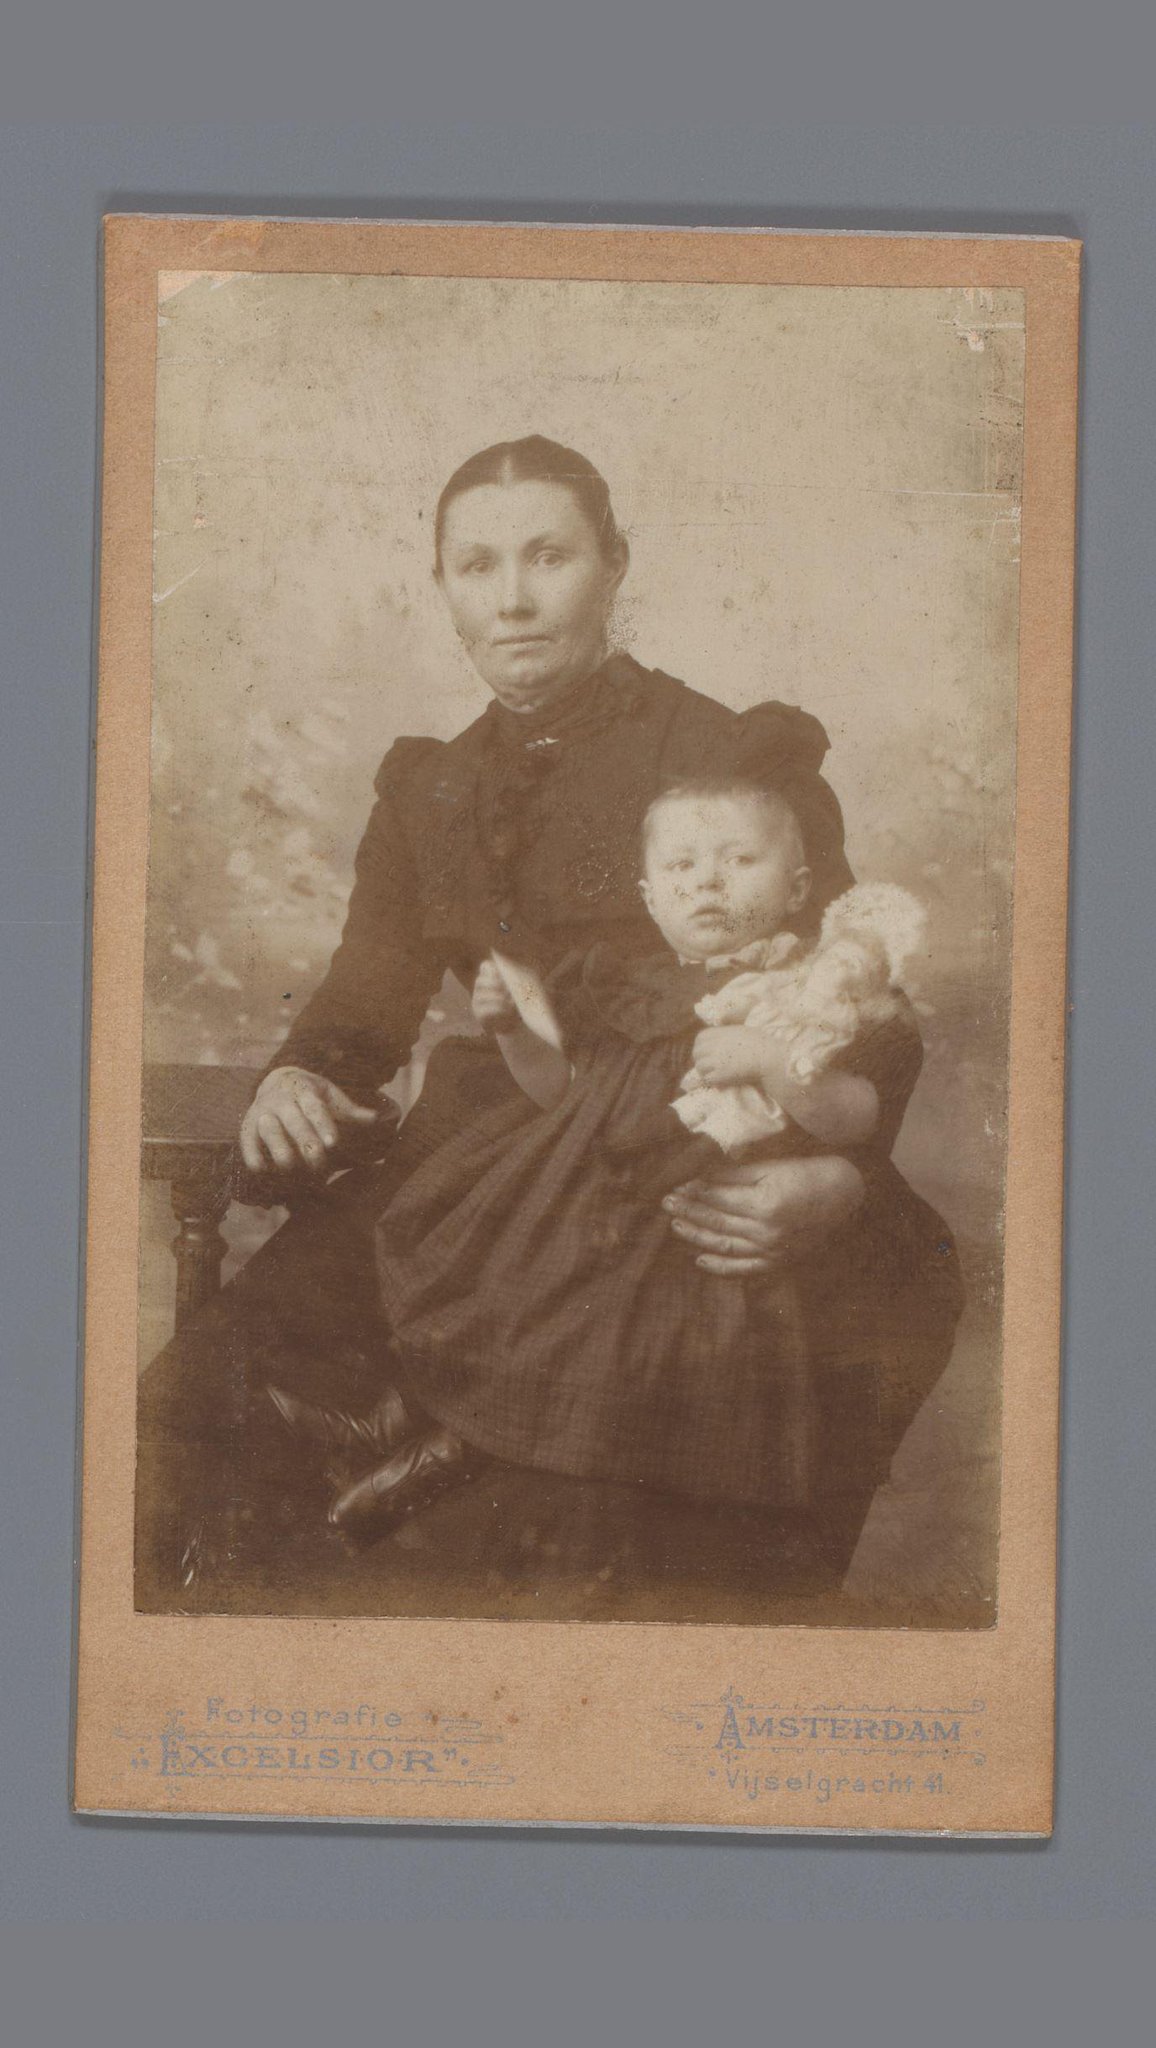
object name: carte de visite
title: Portret van een onbekende vrouw met kind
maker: wilhelmus johannes van pampus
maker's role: fotograaf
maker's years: 1860-1920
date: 1887-1888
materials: paper, cardboard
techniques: collodion silver print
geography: amsterdam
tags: anonymous historical person portrayed, mother and baby or young child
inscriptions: address: ‘Amsterdam/ Vijselgracht 41.’